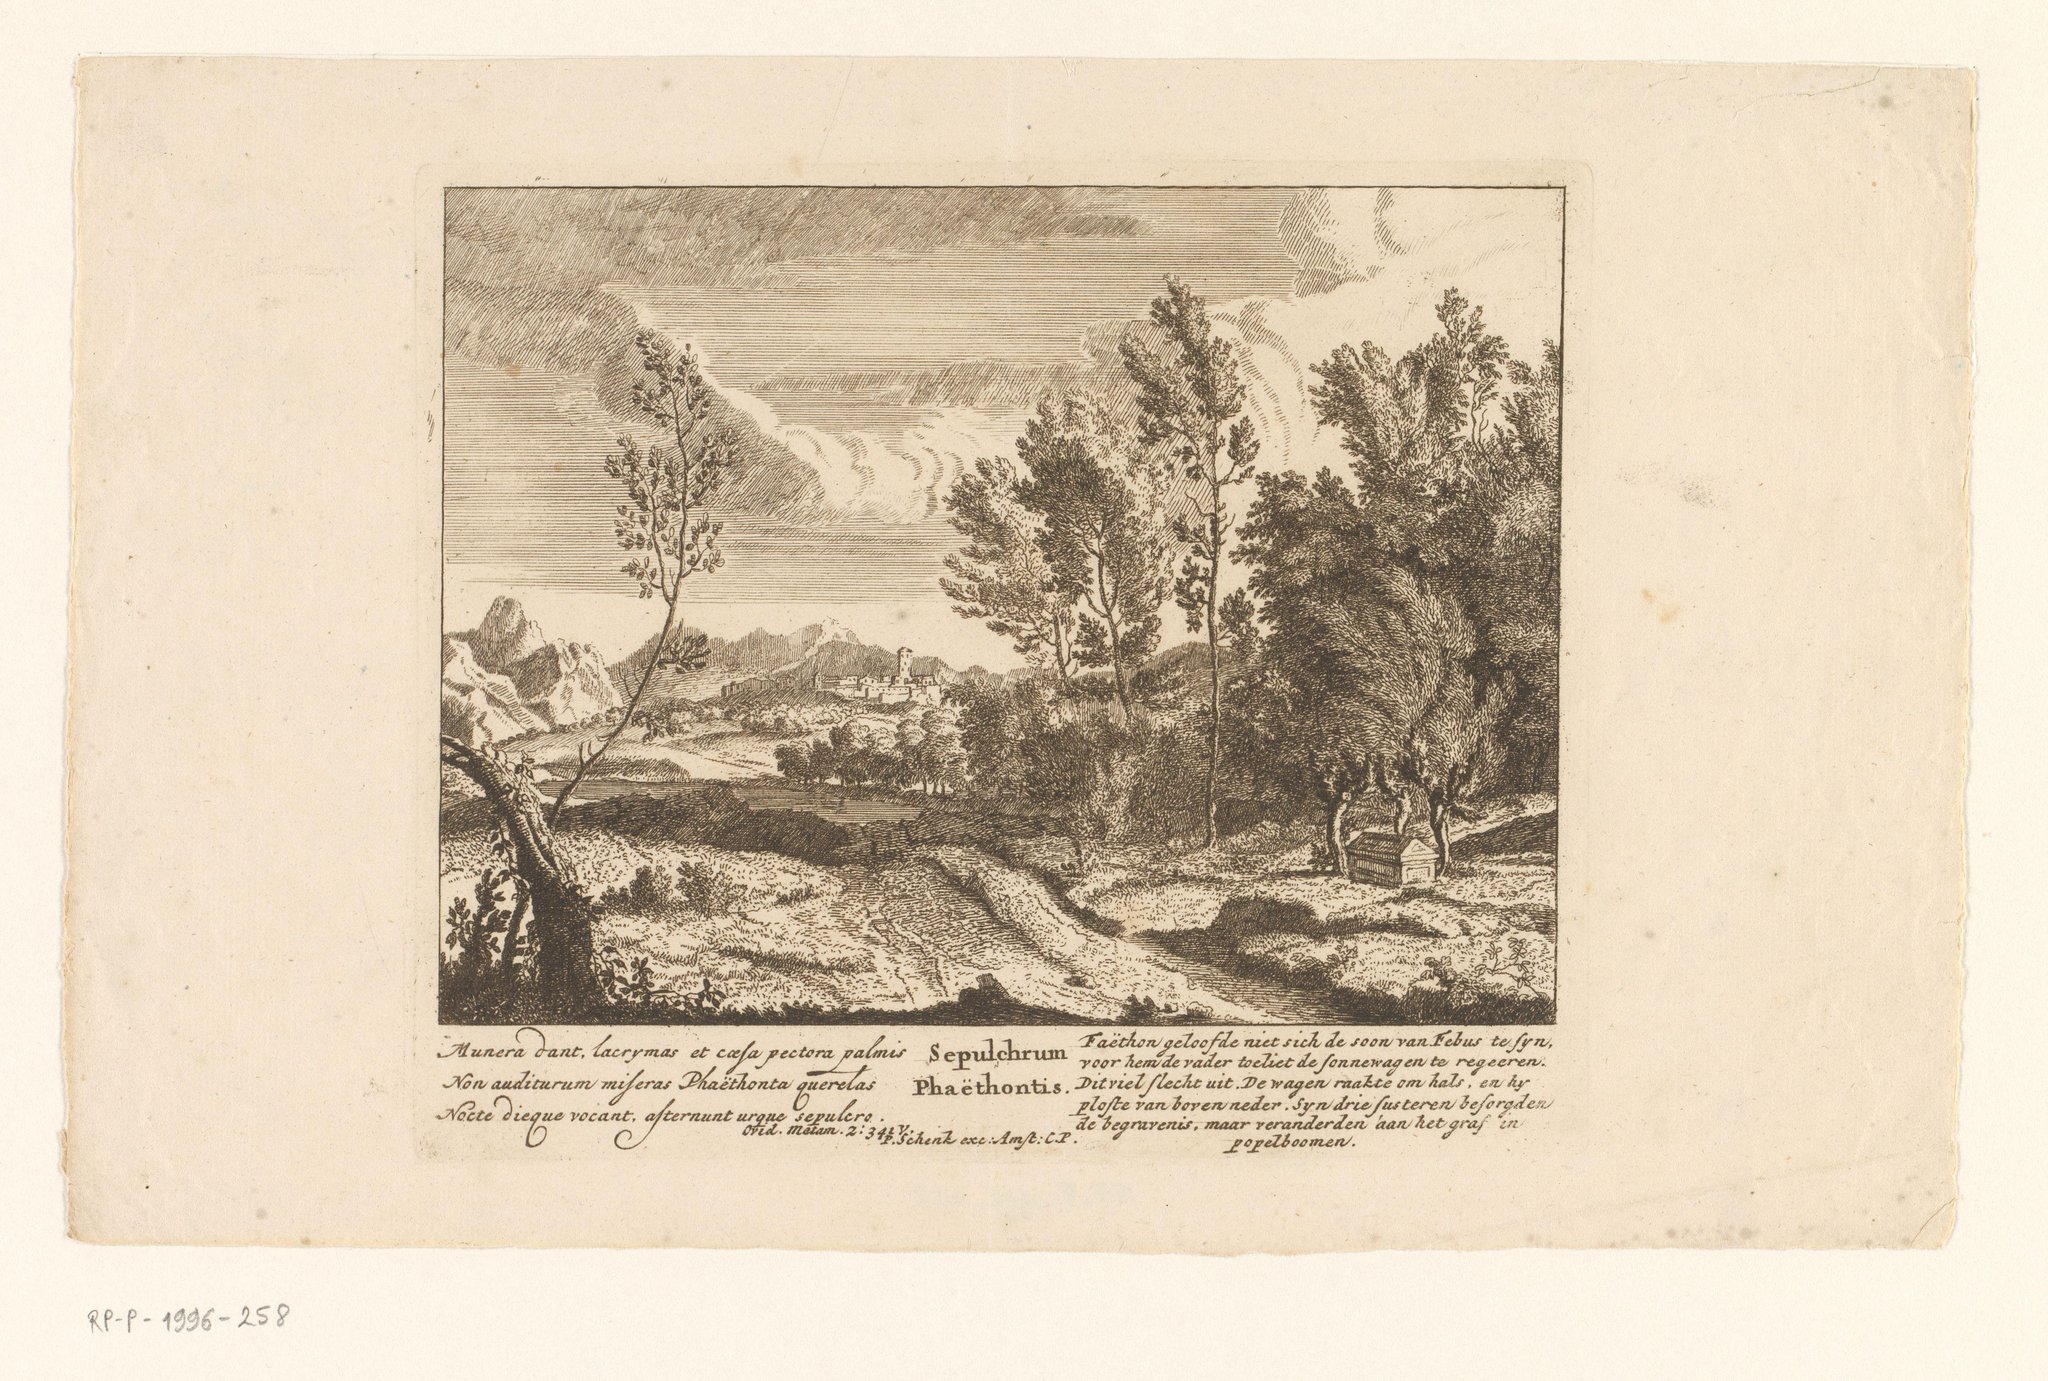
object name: print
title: Sepulchrum Phaëthontis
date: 1680-1713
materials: paper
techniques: etching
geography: amsterdam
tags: phaethon, heliades changed into poplar-trees: while weeping over phaeton's grave the heliades are changed into poplar-trees, and their tears turn into beads of amber; their mother clymene may be present (ovid, metamorphoses ii 346)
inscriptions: inscription: ‘J.D’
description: De bomen rondom de graftombe zijn de zussen van Phaëton die na de begrafenis in populieren zijn veranderd. Met onder de voorstelling drie regels in het Latijn uit de Metamorfosen van Ovidius en zesregelige verklaring van de afbeelding in het Nederlands.